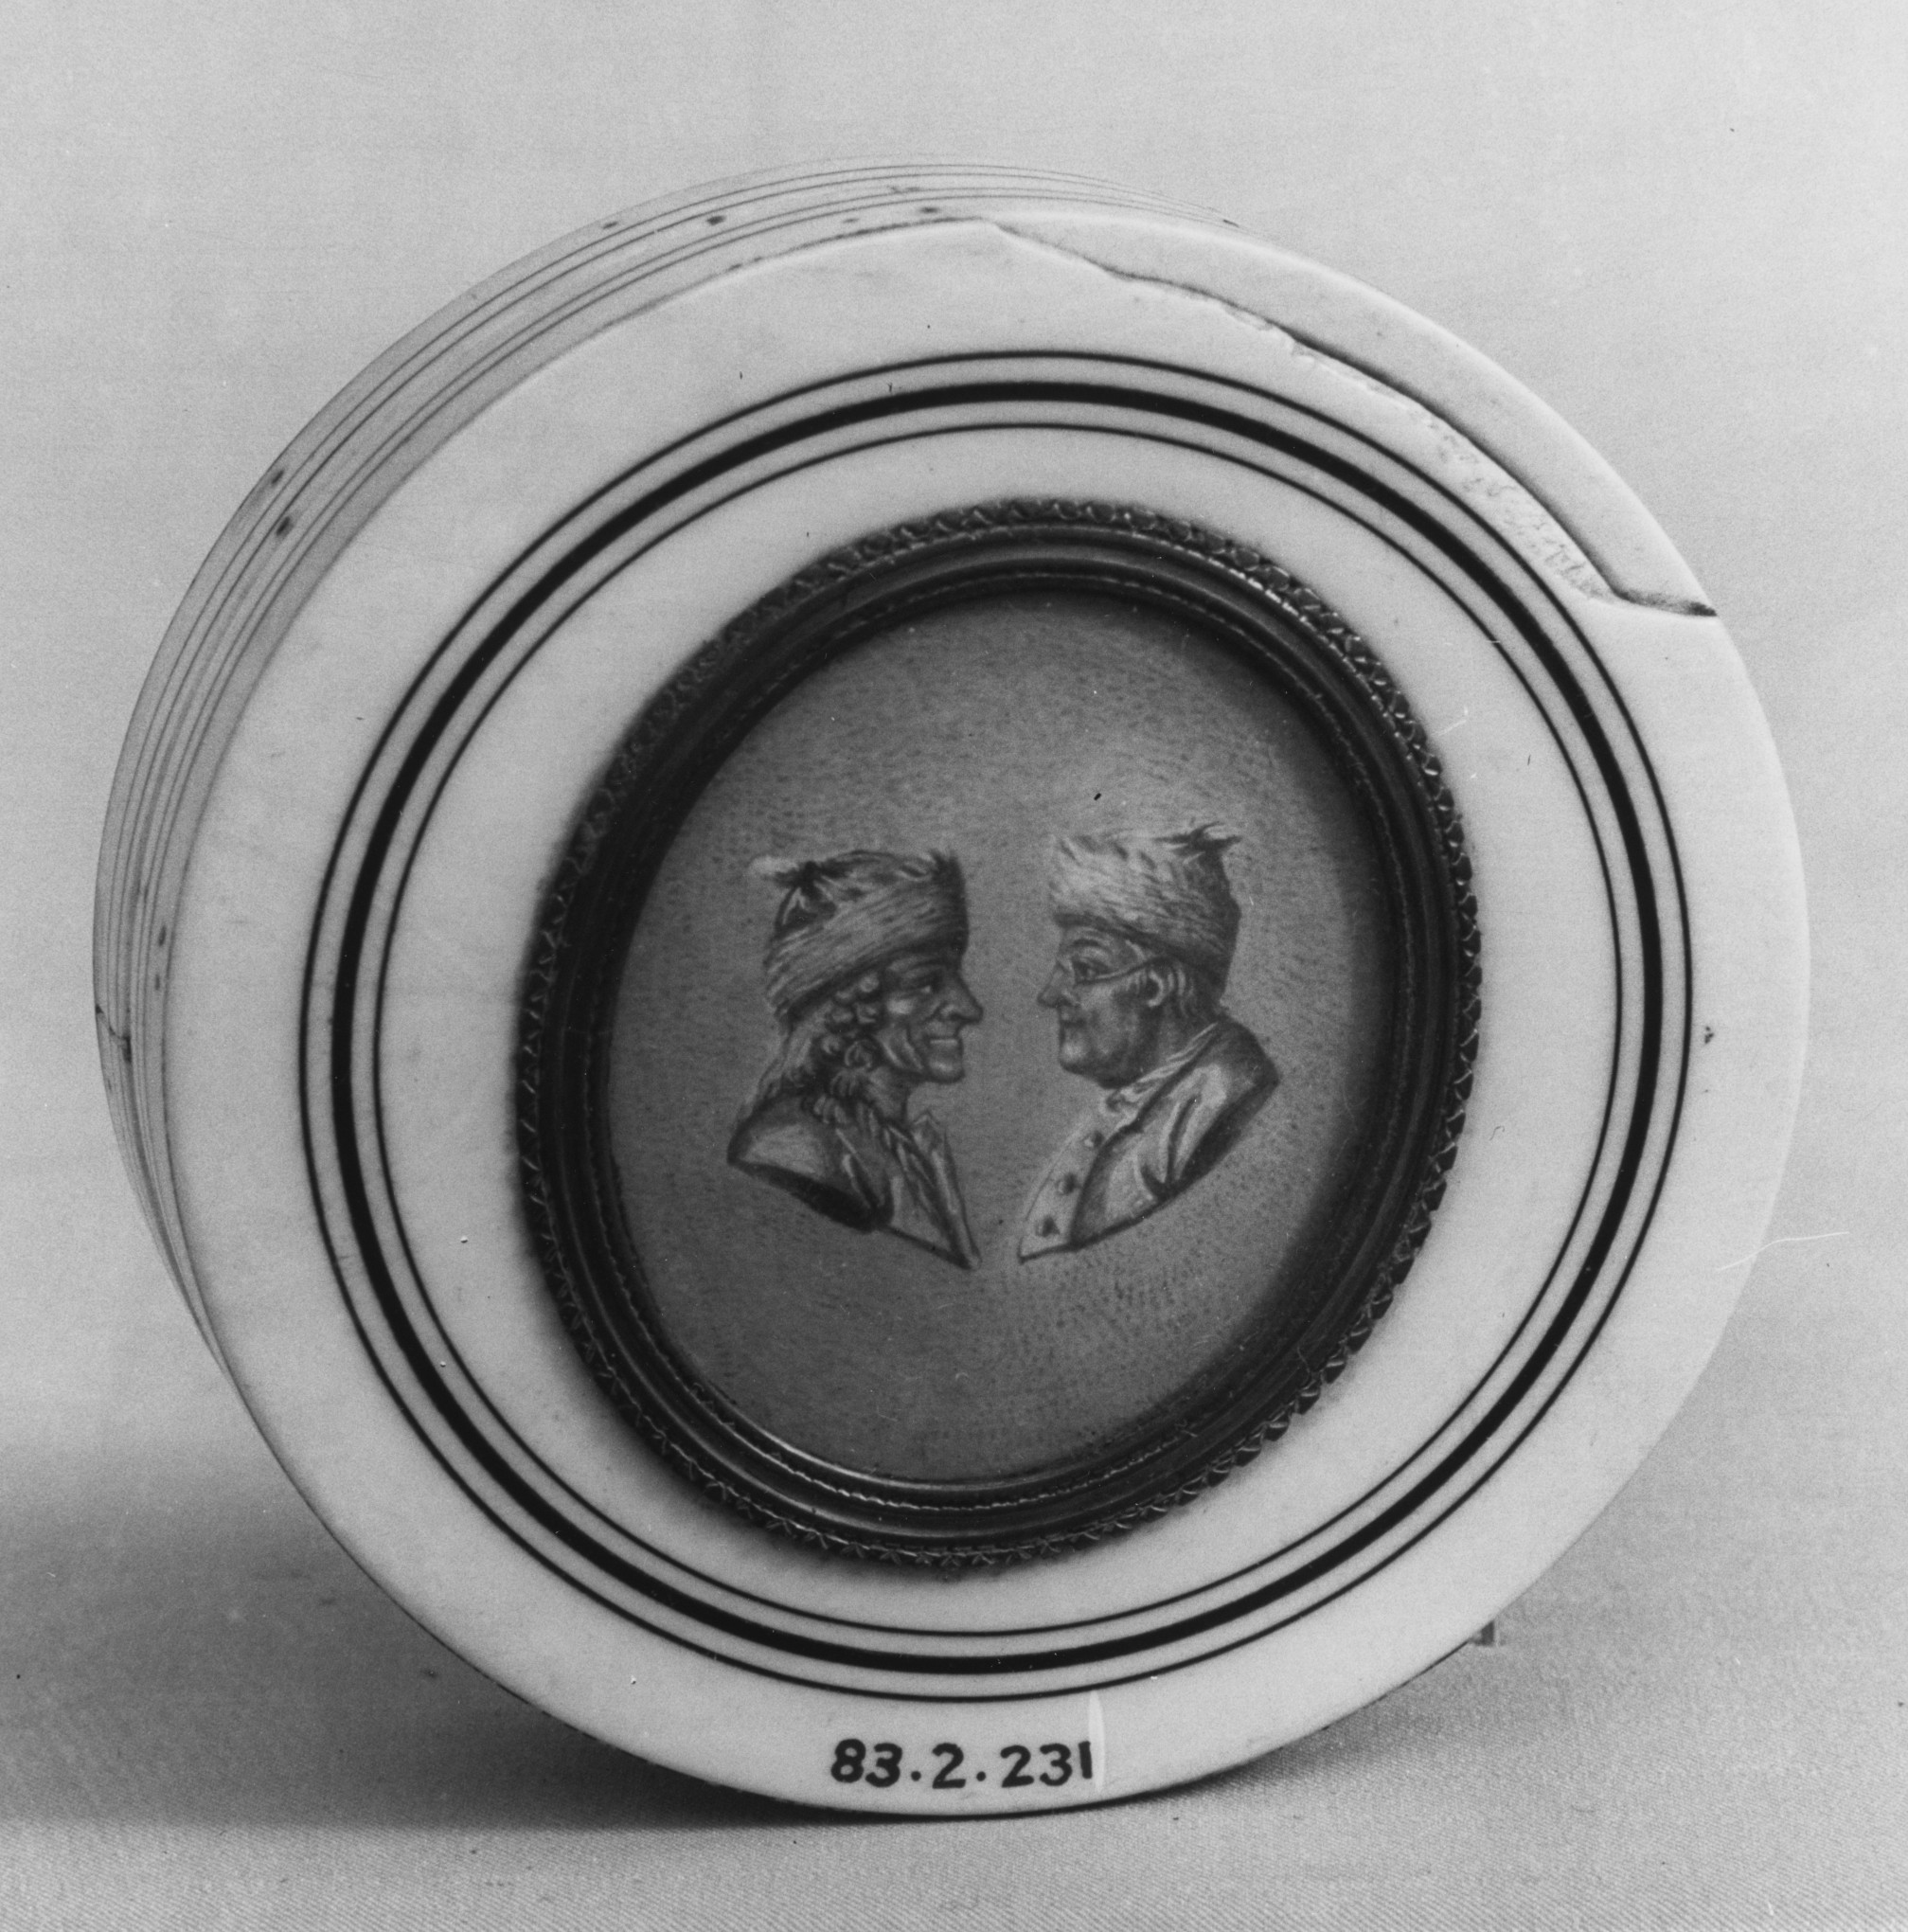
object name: box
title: Box with Medallion Top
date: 1760-1883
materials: ivory, porcelain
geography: france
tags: benjamin franklin,men